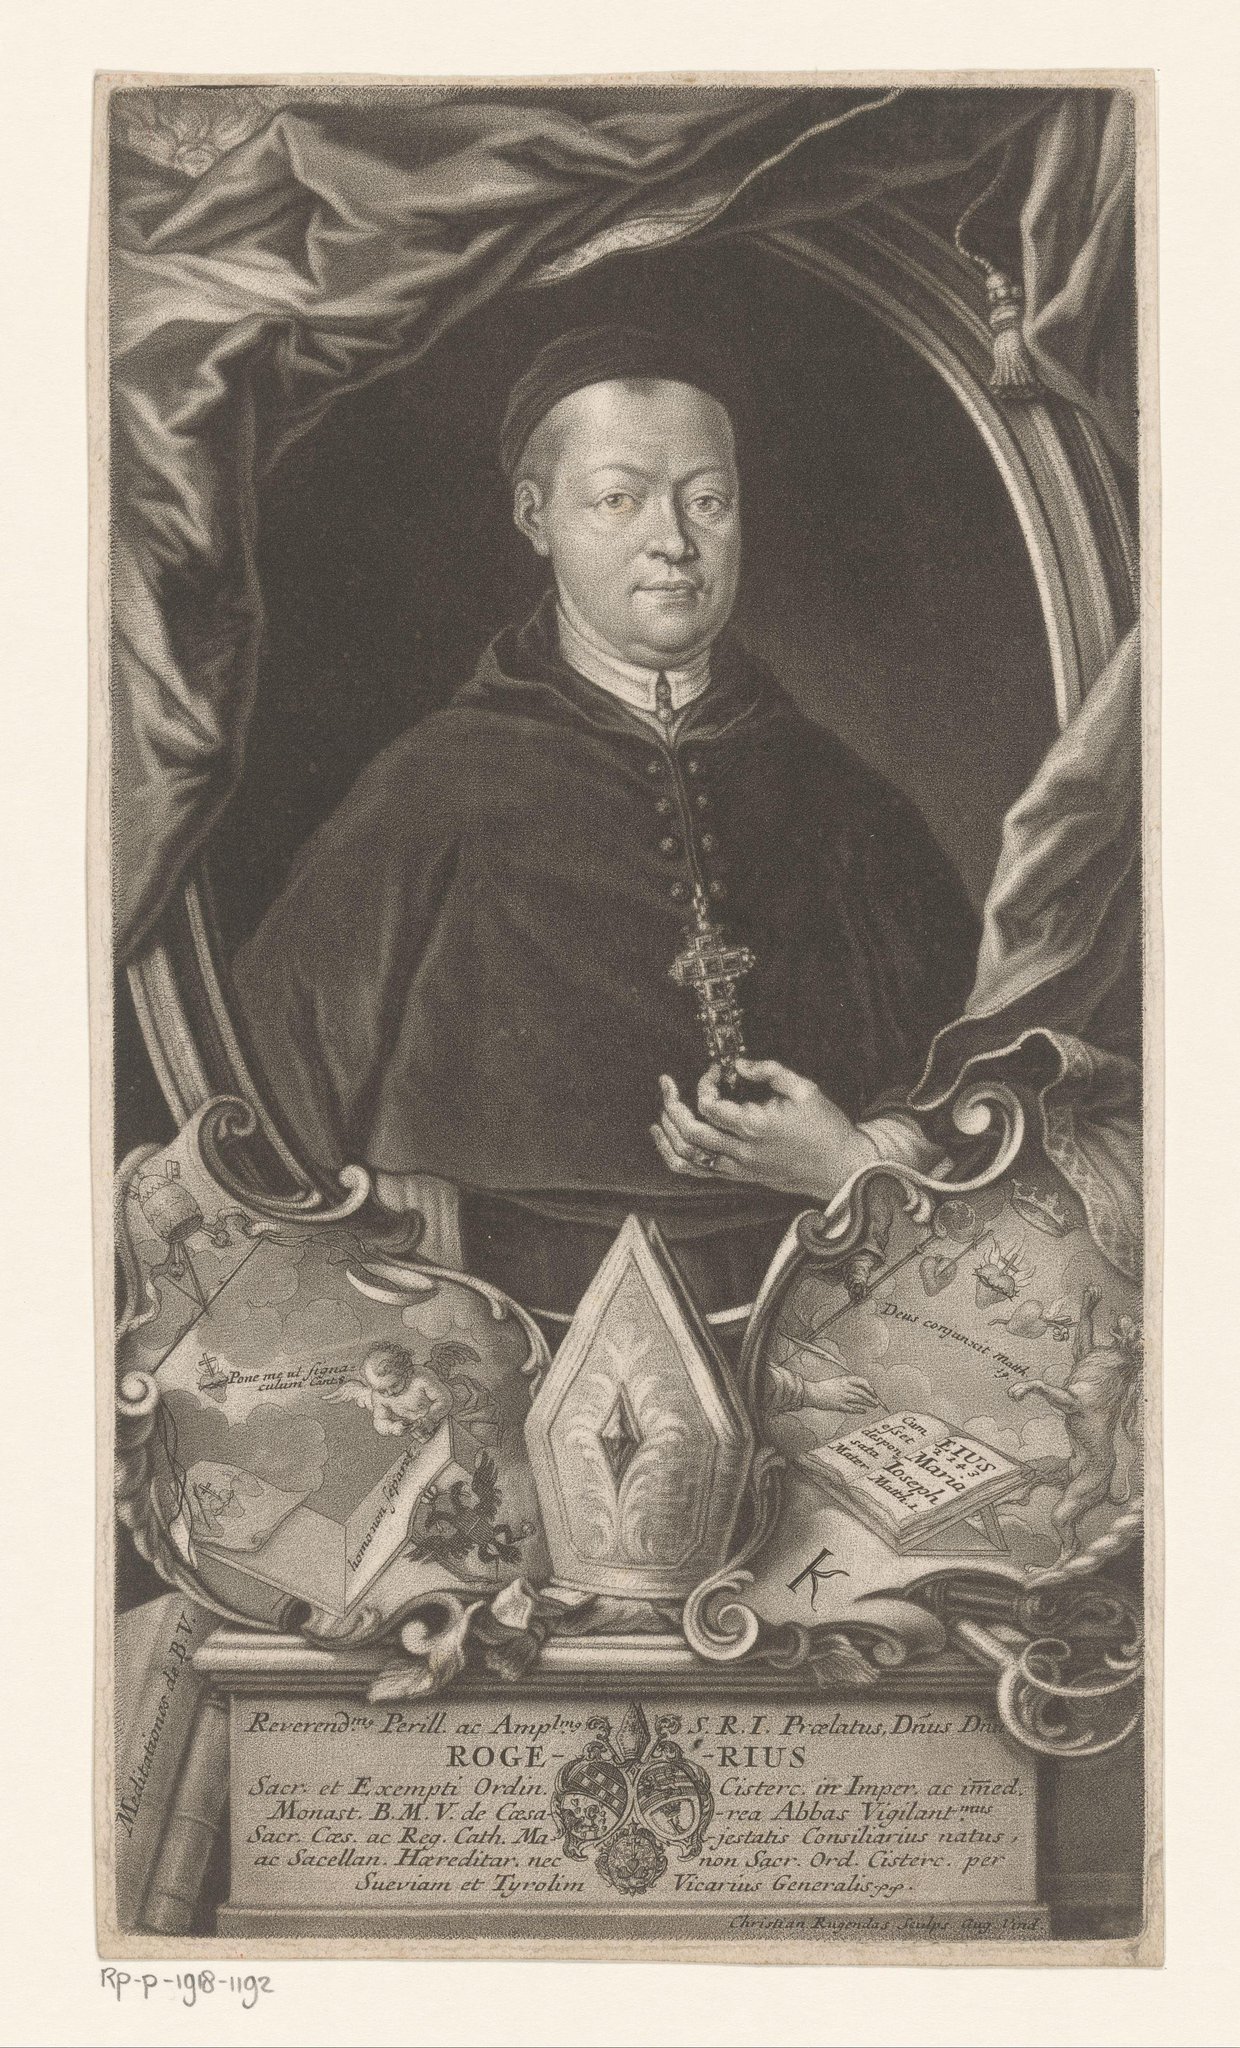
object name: print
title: Portret van Rogerius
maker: christian rugendas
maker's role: print maker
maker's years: 1708-1781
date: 1718-1781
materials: paper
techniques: etching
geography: augsburg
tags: insignia of bishop, e.g. mitre, crozier, historical persons, abstract ideas and concepts (+ emblematical representation of concept), armorial bearing, heraldry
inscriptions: collector's mark: Lugt 2233